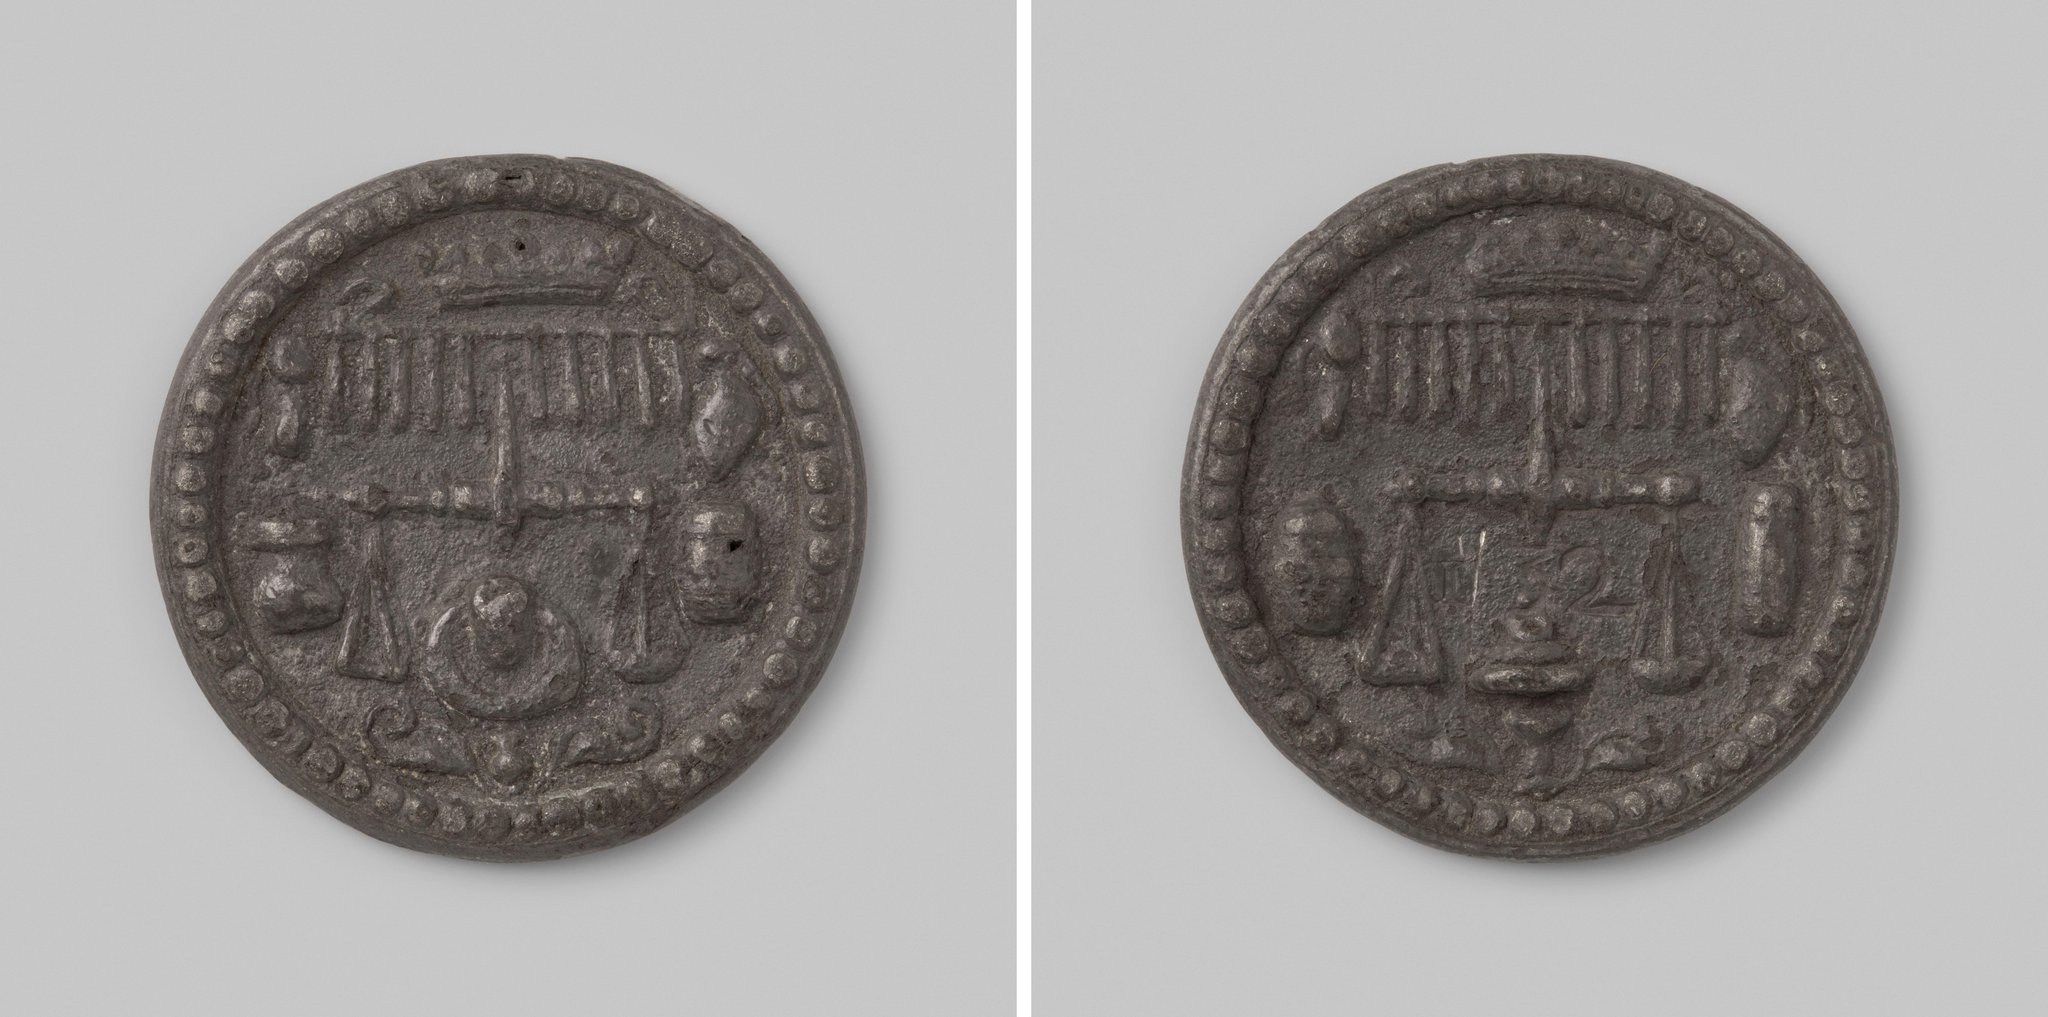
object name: medal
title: Presentiepenning van het Vettewariersgilde te Middelburg 1684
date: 1684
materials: tin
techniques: casting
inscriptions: inscription: ‘132’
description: Gegoten tinnen penning, op de voorzijde een gekroonde balans, een stok met kaarsen en hammen, twee vaten, kazen en een glas, het getal 132 ingestempeld, de keerzijde eender met een boterkuipje in plaats van kazen,